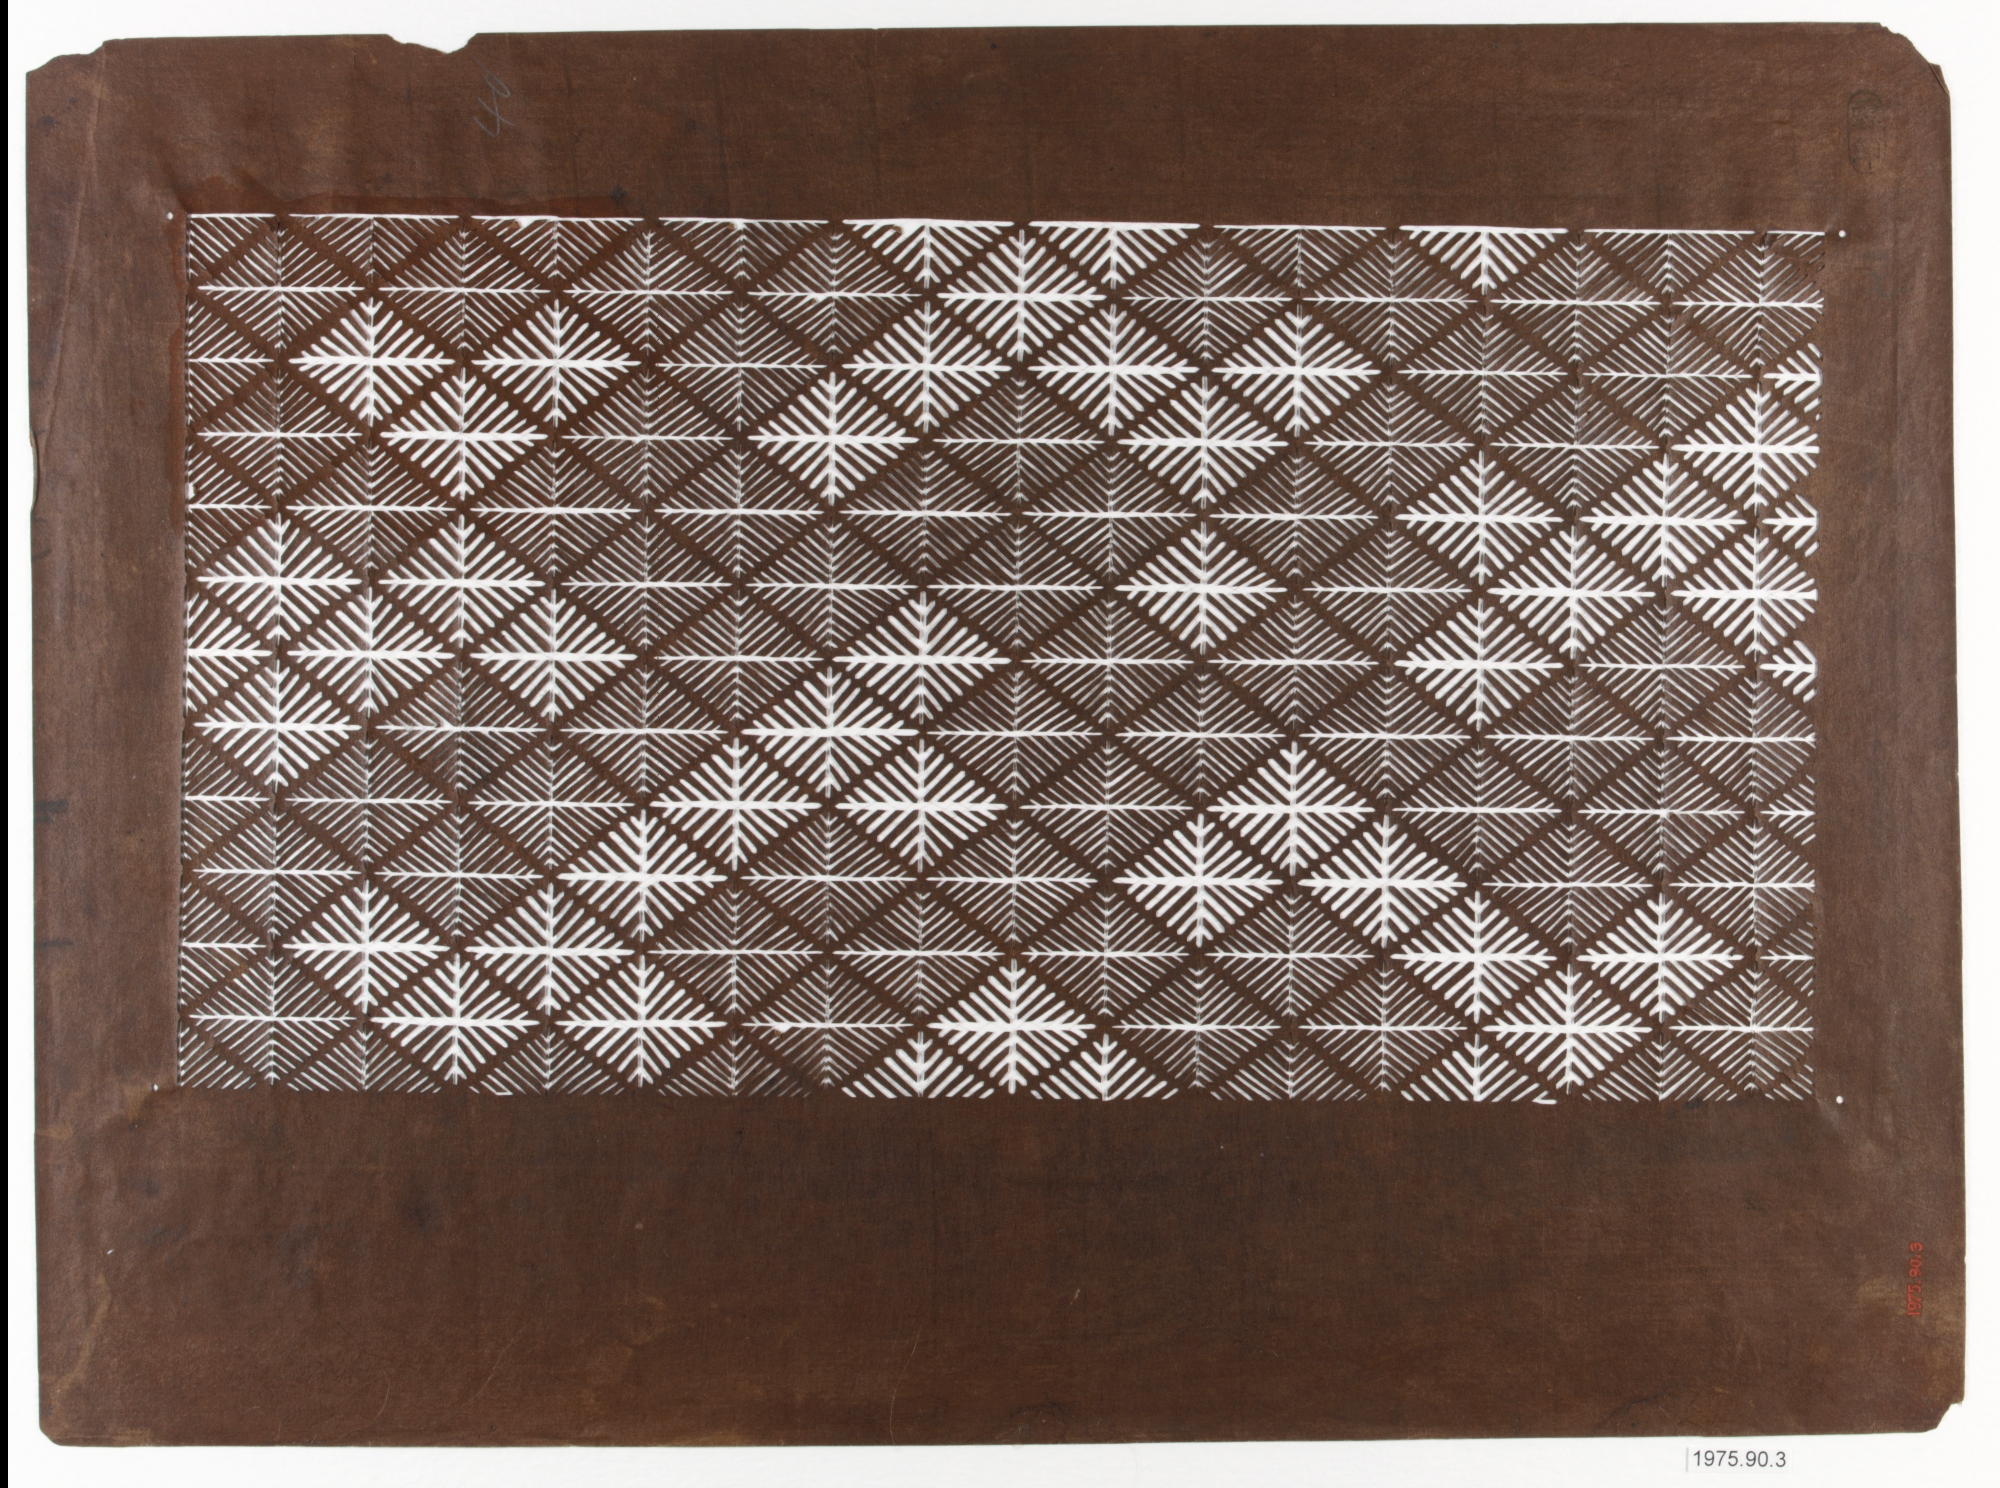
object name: stencil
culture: japanese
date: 1867-1933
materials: paper, silk